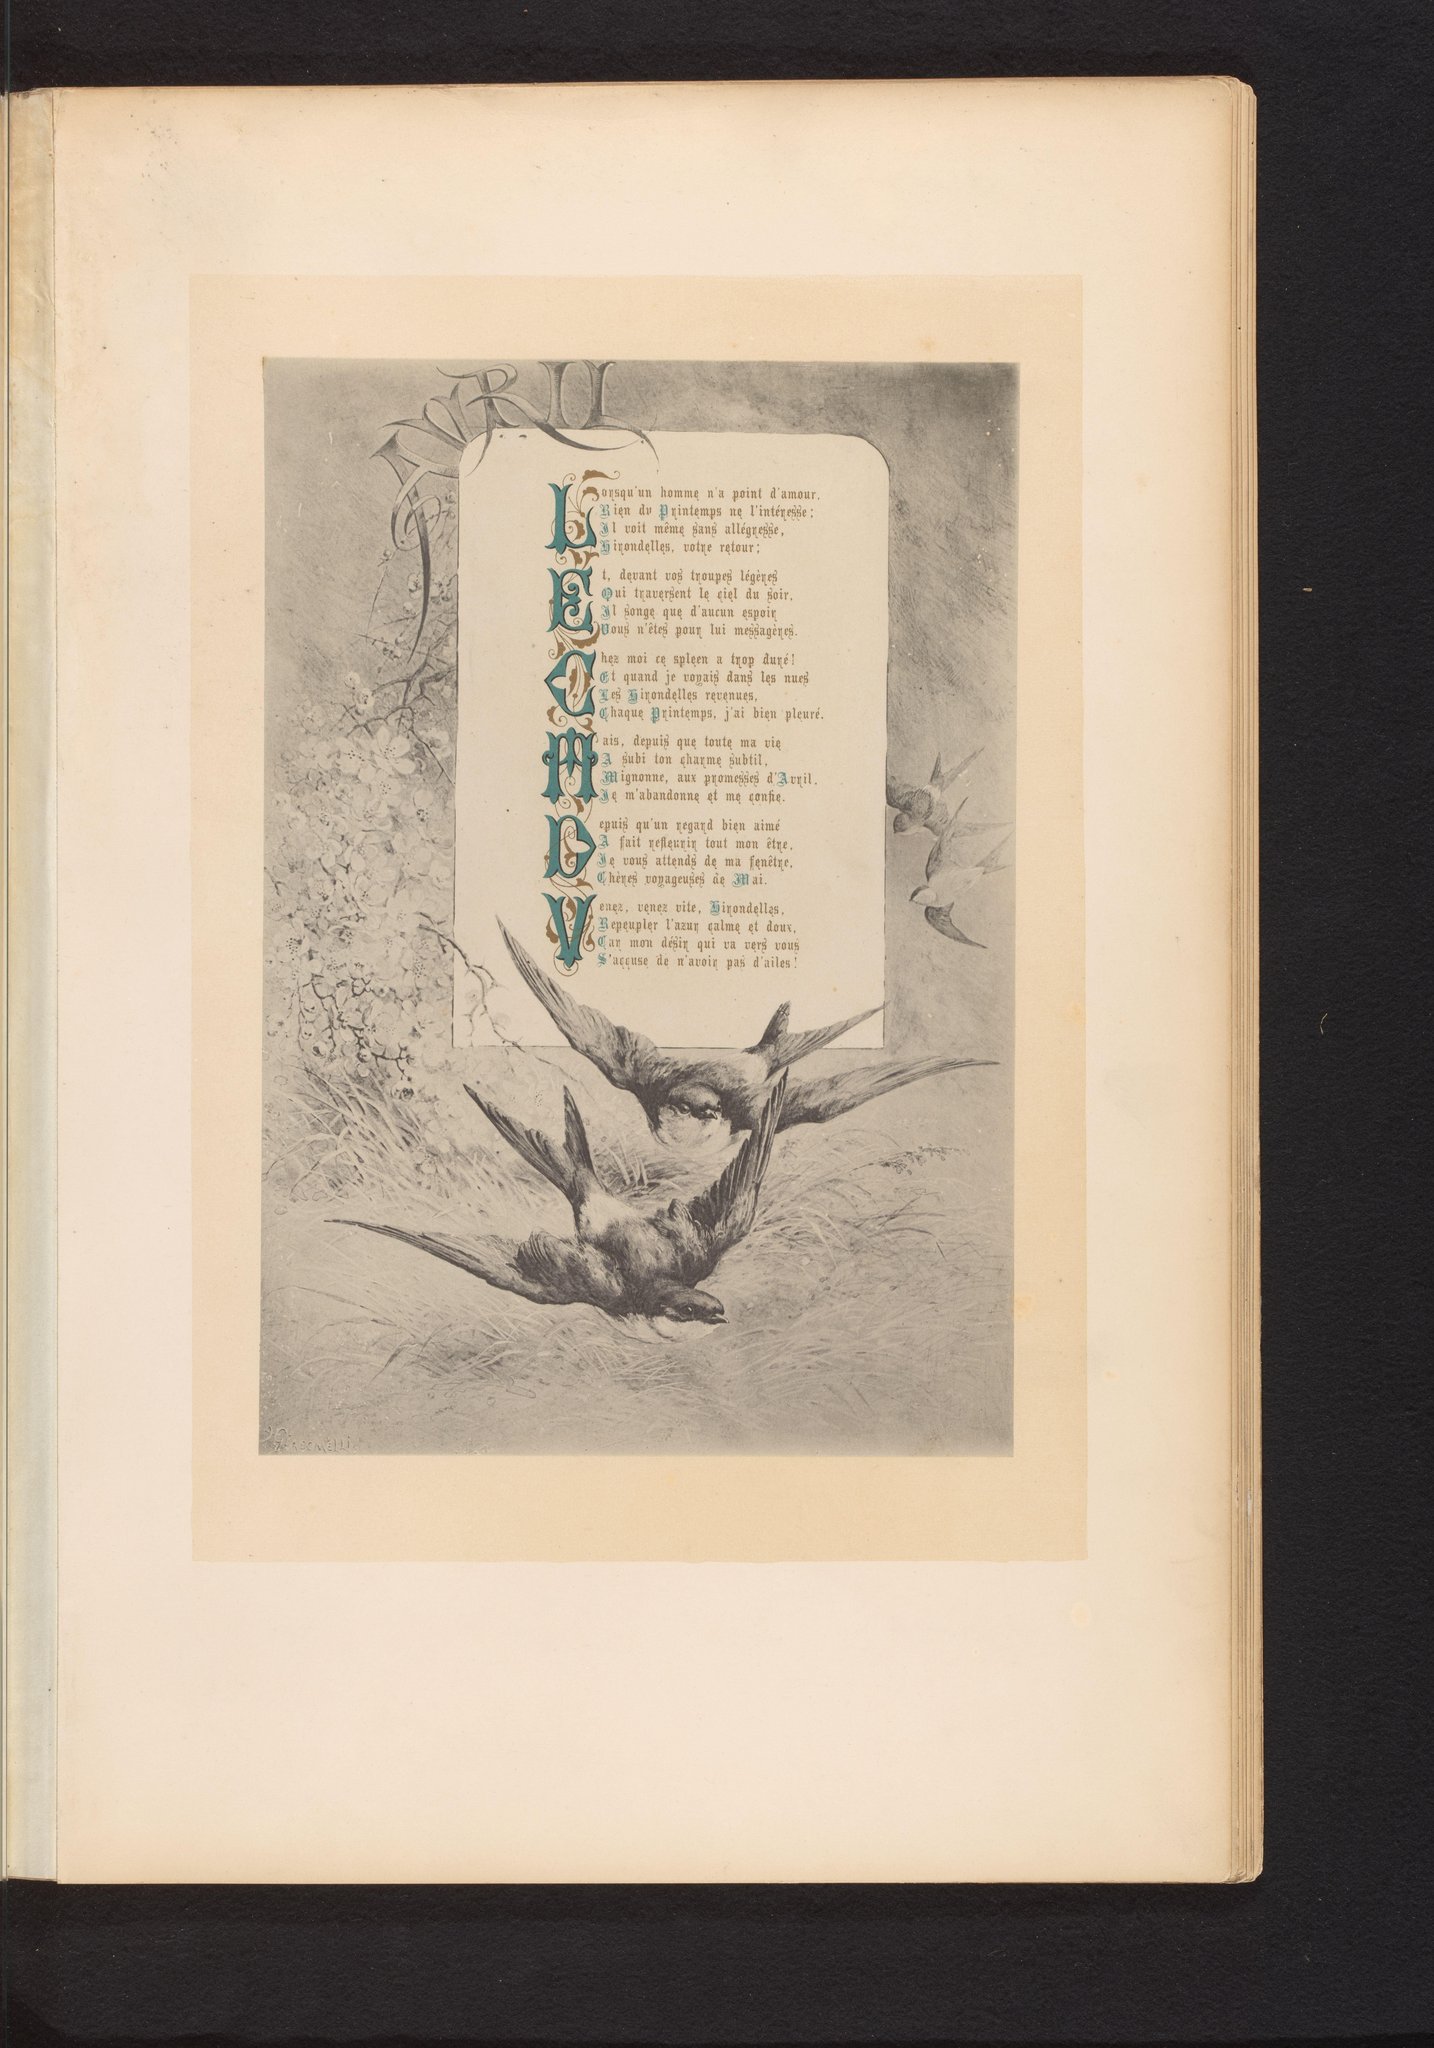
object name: page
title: Reproductie van een prent van vier vliegende vogels en een tak met bloesem, met het gedicht Avril van François Coppée, door Hector Giacomelli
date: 1871-1876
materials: paper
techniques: chromolithography, photograph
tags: birds, april ~ other concepts